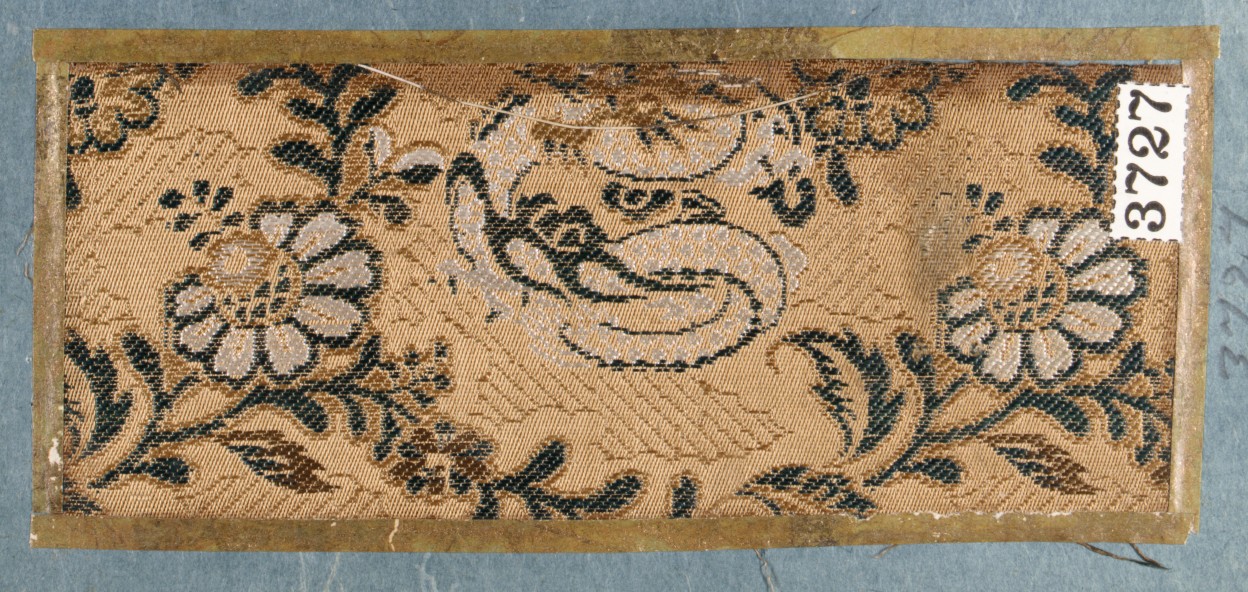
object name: sample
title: Textile Sample from Sample Book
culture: japanese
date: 1801-1900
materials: silk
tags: flowers